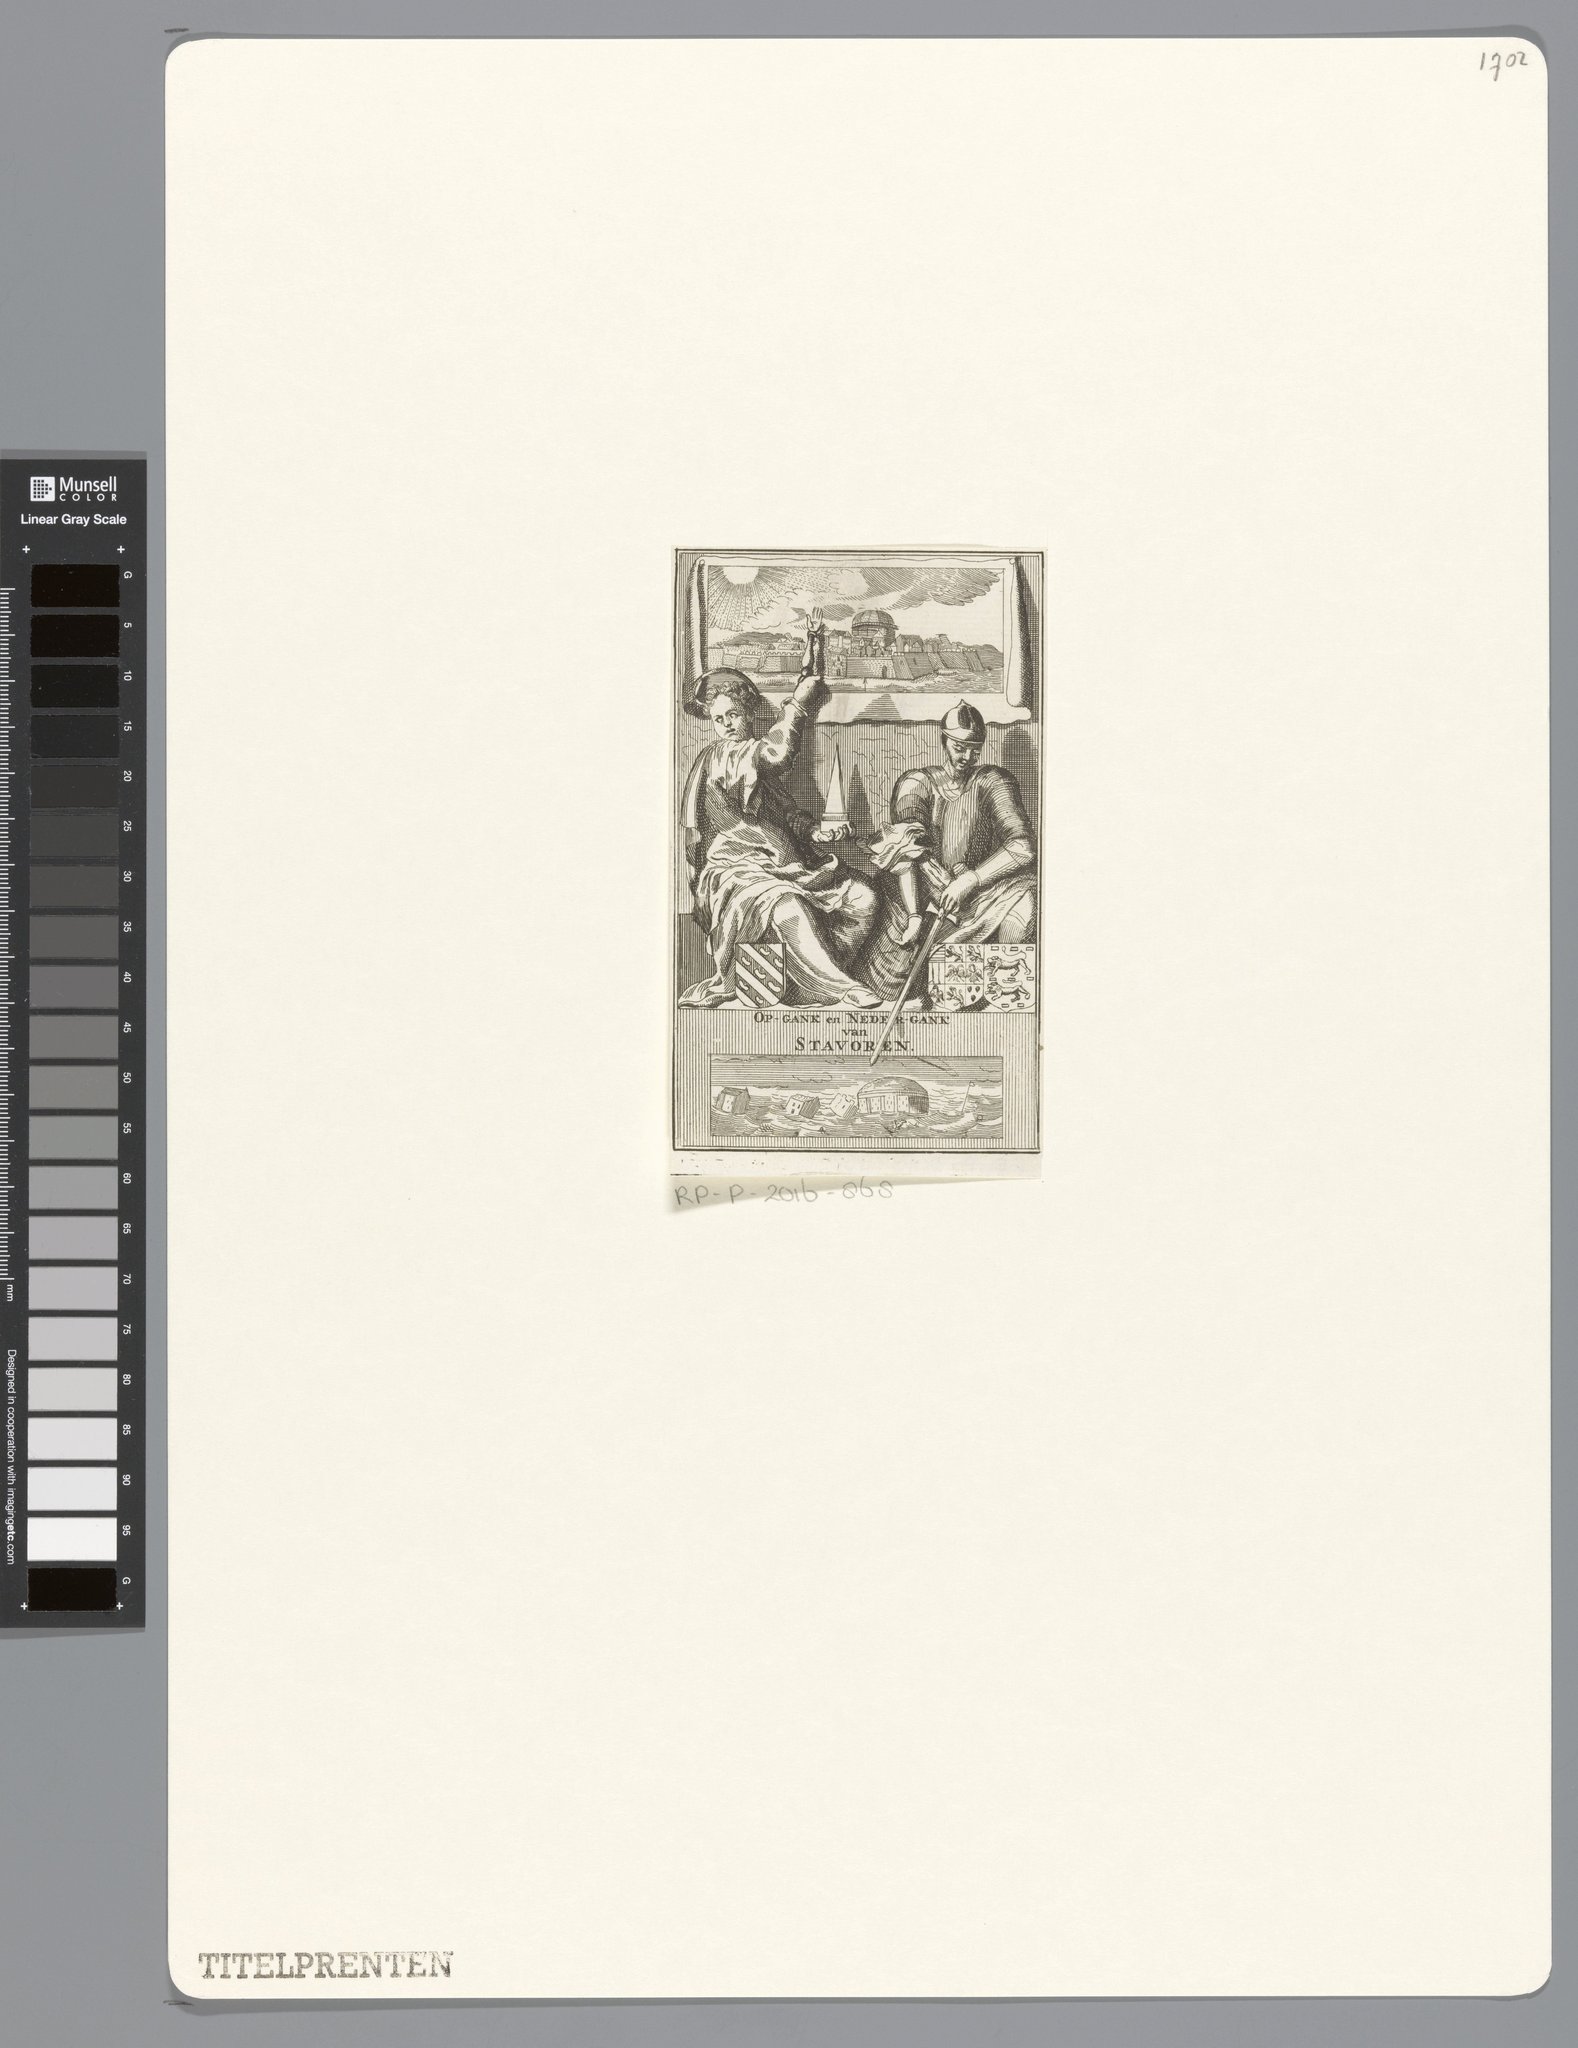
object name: print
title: Allegorie op bloei en verval van Stavoren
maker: pieter van den berge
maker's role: draughtsman, print maker, printer, publisher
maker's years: 1659-1737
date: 1702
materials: paper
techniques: etching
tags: city represented symbolically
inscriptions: collector's mark: Lugt 2228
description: Allegorische vrouwenfiguur zittend naast een soldaat met de wapens van Friesland en Stavoren. Boven de stad Stavoren in bloei, onder de stad in verval.